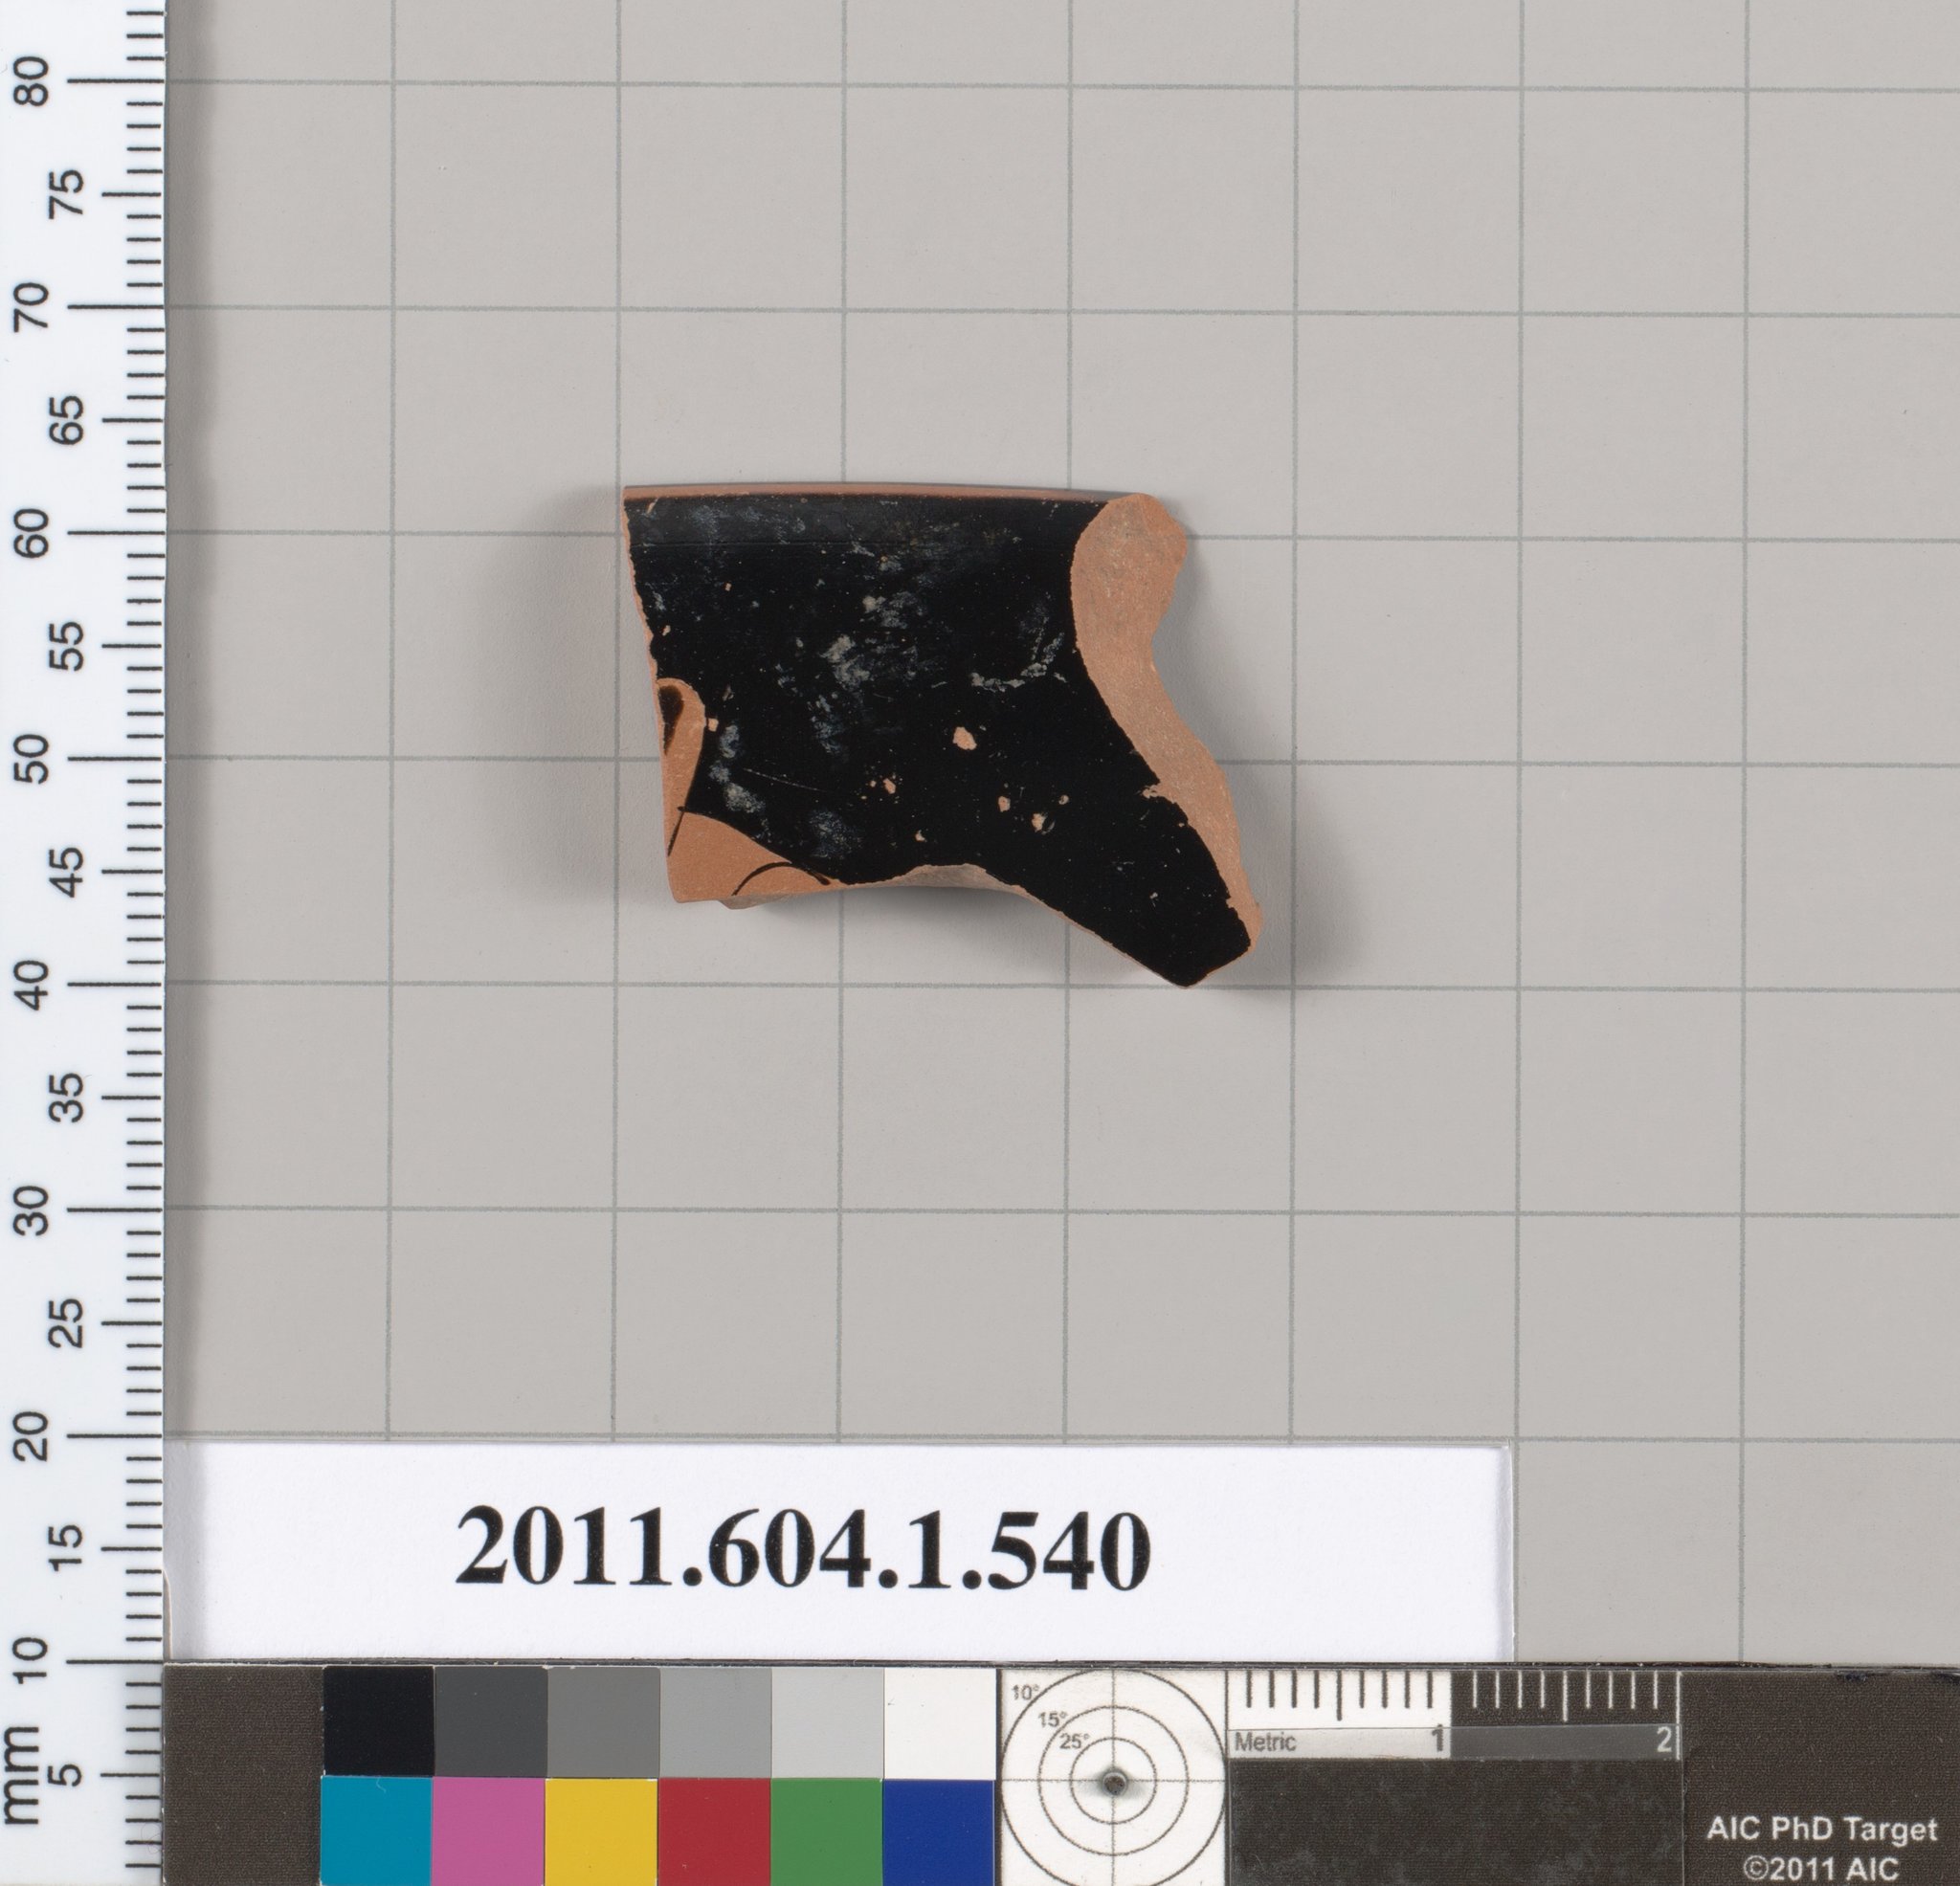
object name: kylix fragment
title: Terracotta rim fragment of a kylix (drinking cup)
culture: greek, attic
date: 480-470 BCE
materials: terracotta